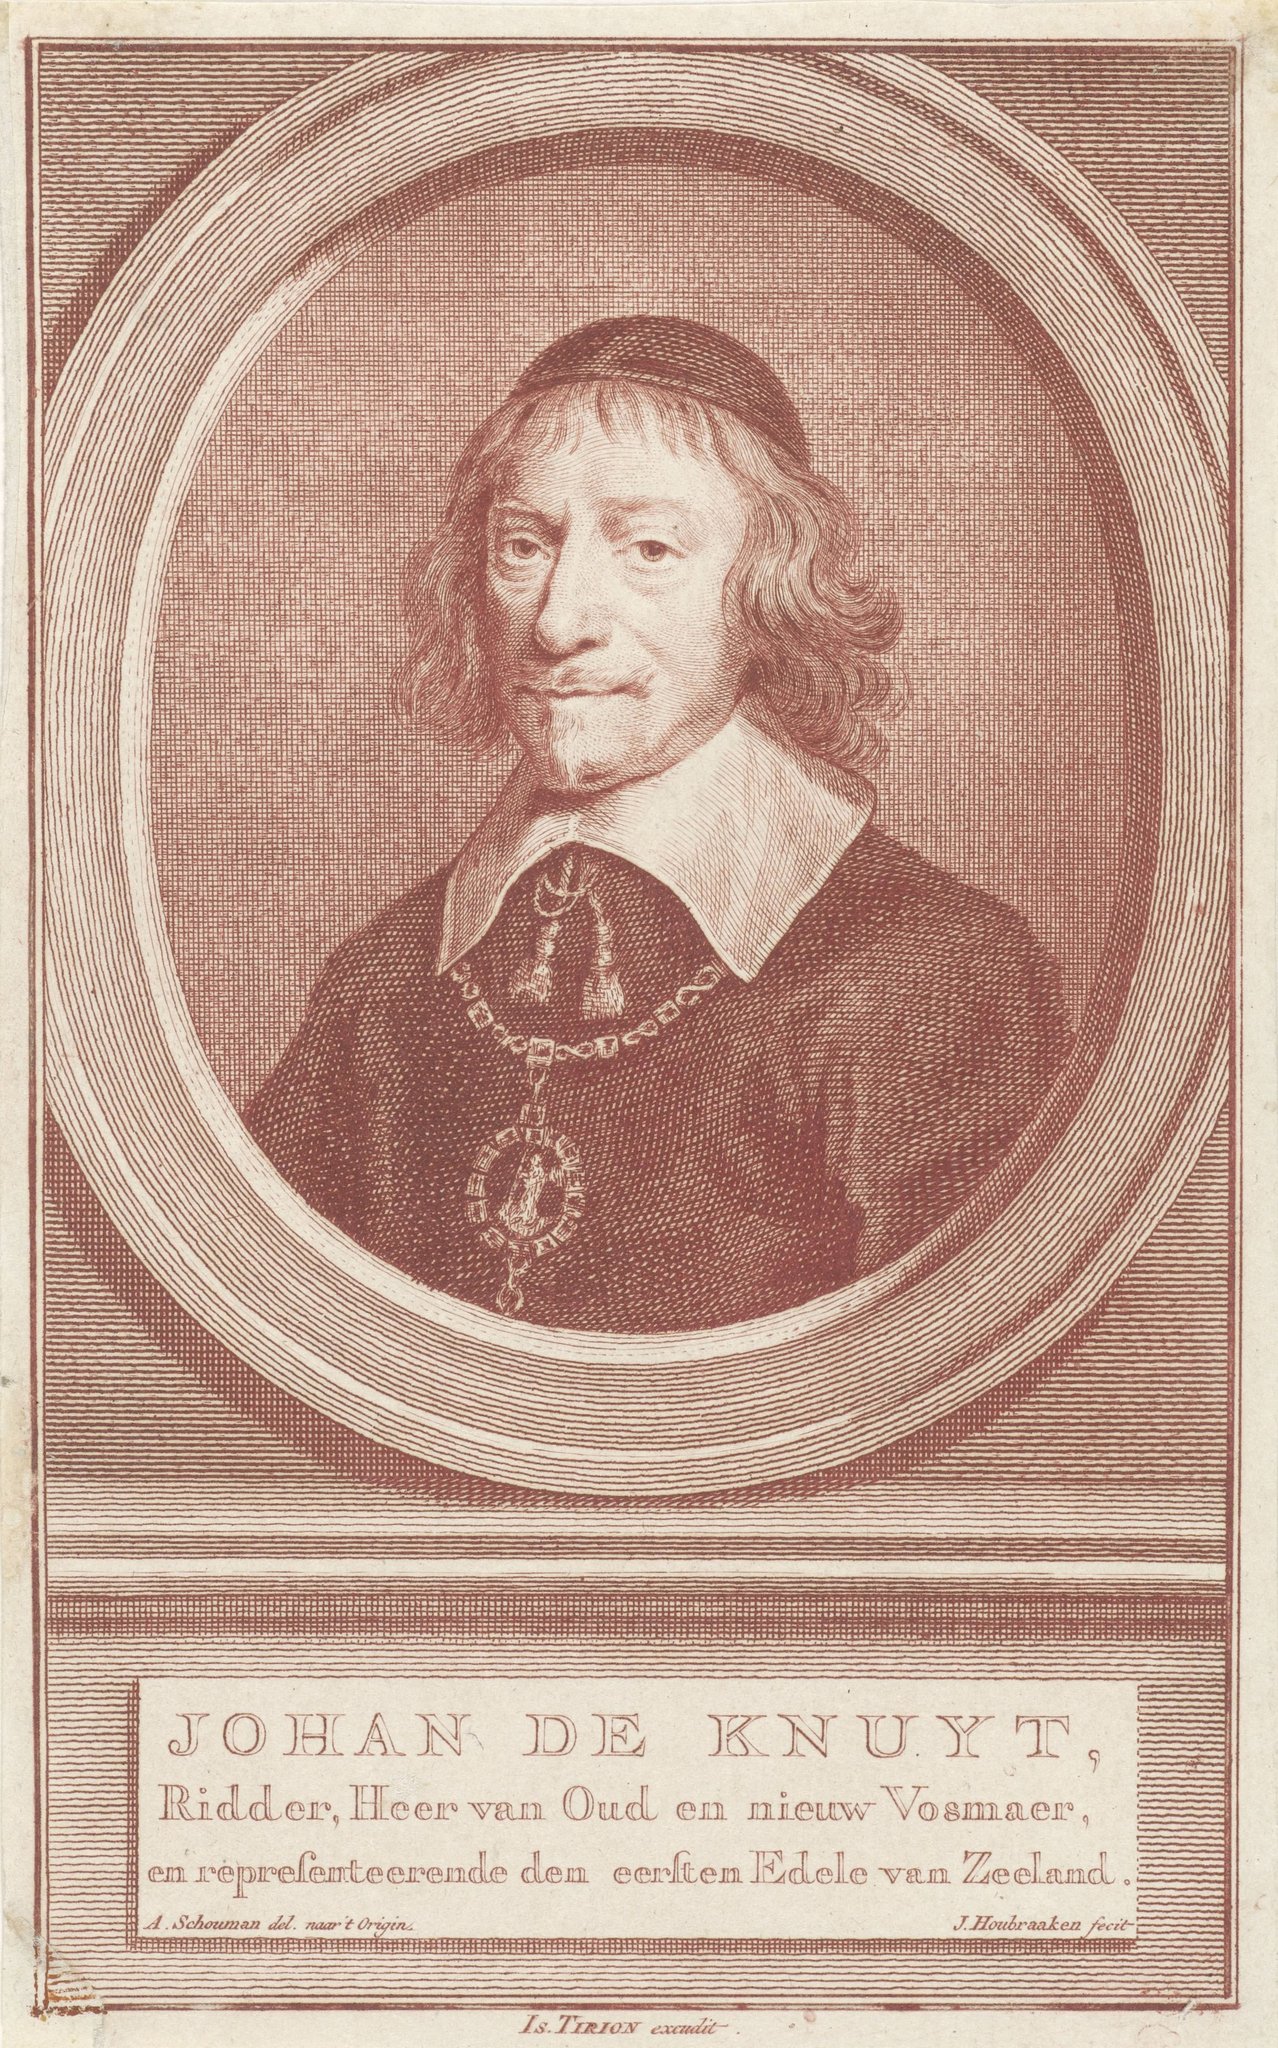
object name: print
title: Johan de Knuyt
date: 1749-1759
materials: paper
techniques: engraving, etching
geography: amsterdam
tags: johan de knuyt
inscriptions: collector's mark: Lugt 2228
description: Druk in rood. Prent ook gebruikt in: Jan Wagenaar, Vaderlandsche historie, vervattende de geschiedenissen der nu Vereenigde Nederlanden, inzonderheid die van Holland (...), 21 delen. Amsterdam, Isaak Tirion, 1749-59. Druk in rood. Prent volgens Ver Huell ook gebruikt in: Portraiten van eenige der vermaardste staatsmannen en zeehelden, als toevoeging op: Willem Tiberius Hattinga, Atlas van Zeeland. Amsterdam: Isaak Tirion, 1760.